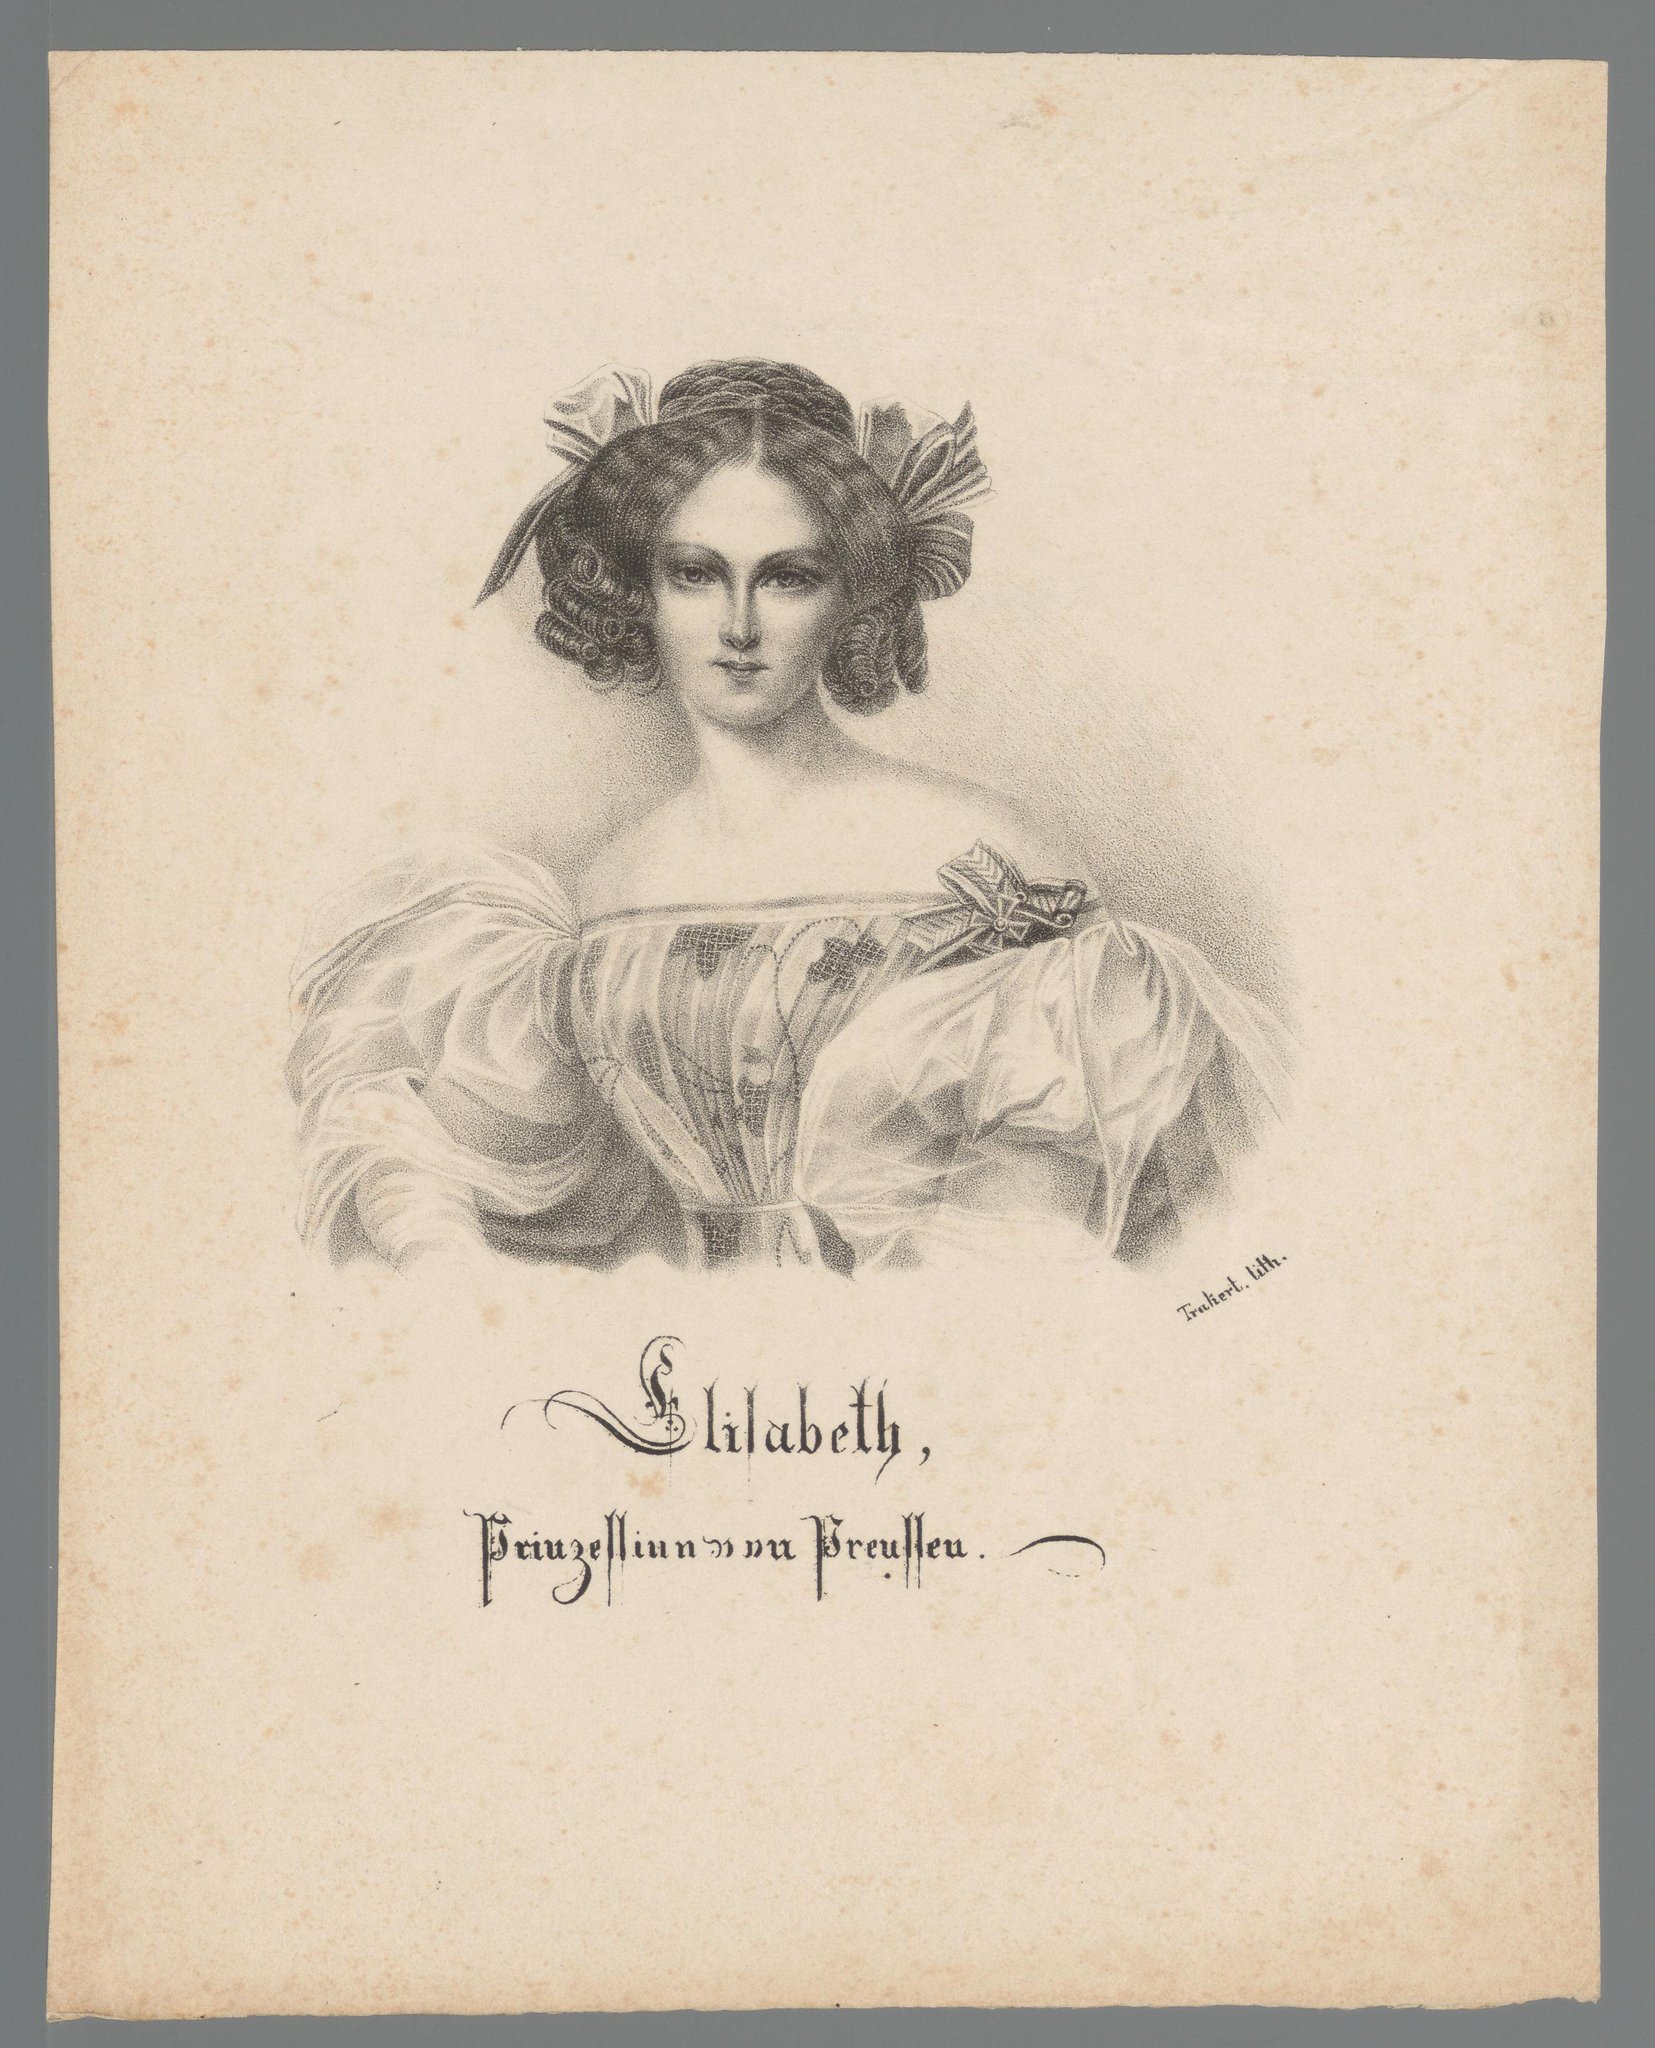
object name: print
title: Portret van Elisabeth van Beieren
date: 1820-1890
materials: paper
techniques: lithograph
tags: adult woman, historical persons, princess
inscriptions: collector's mark: Lugt 2228